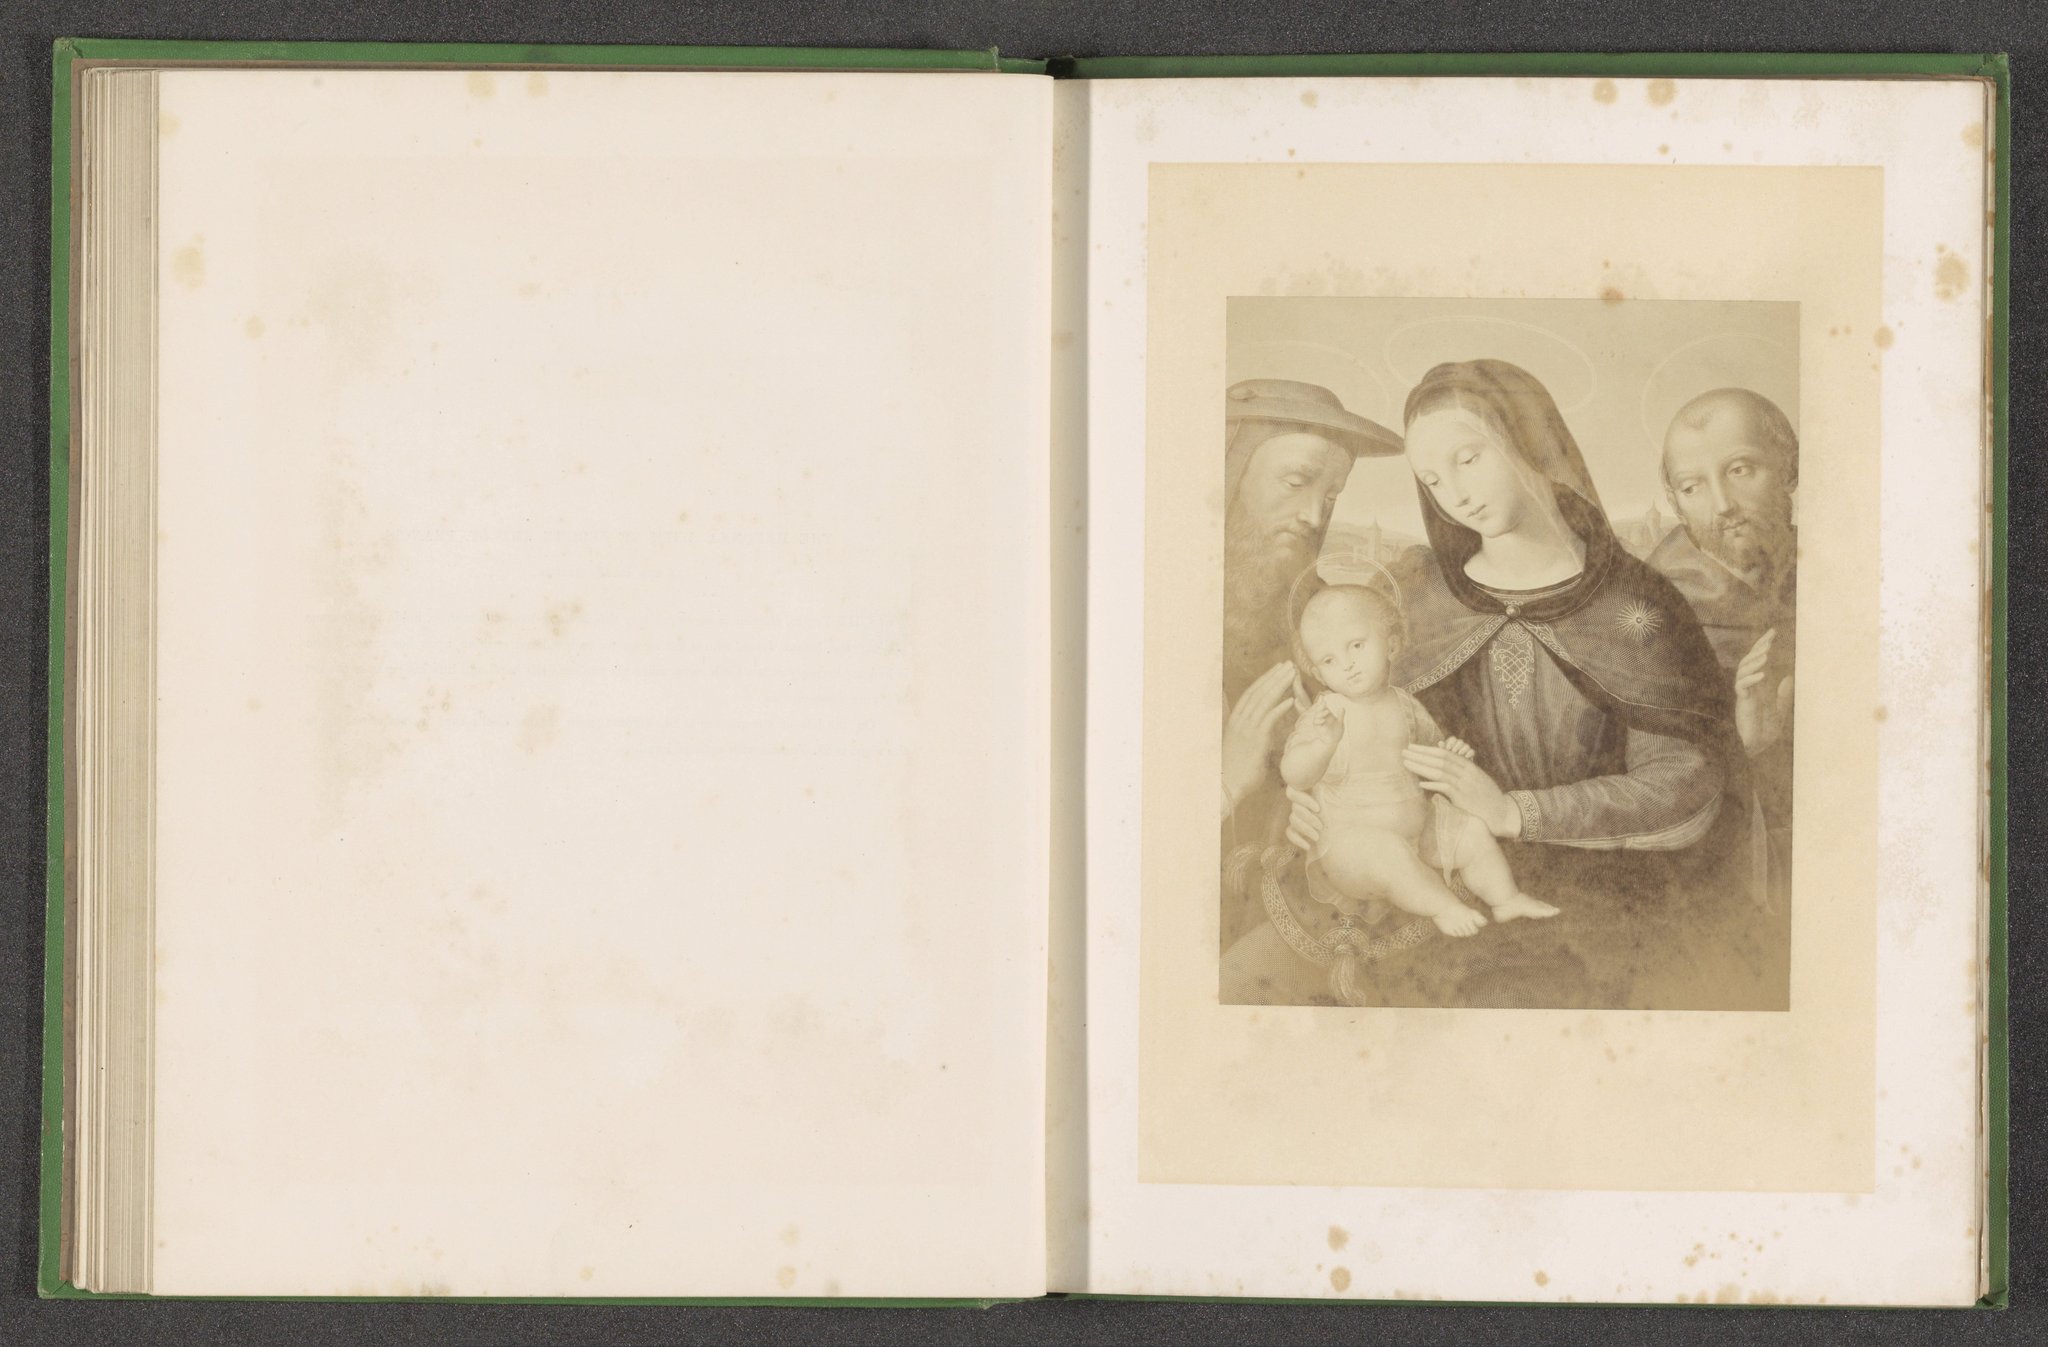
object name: photograph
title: Fotoreproductie van een prent door A. Hoffmann van een Maria met Kind door Rafaël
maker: joseph cundall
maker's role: fotograaf, schrijver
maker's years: 1818-1895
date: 1859-1869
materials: photographic support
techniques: albumen print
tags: madonna accompanied by saint(s)